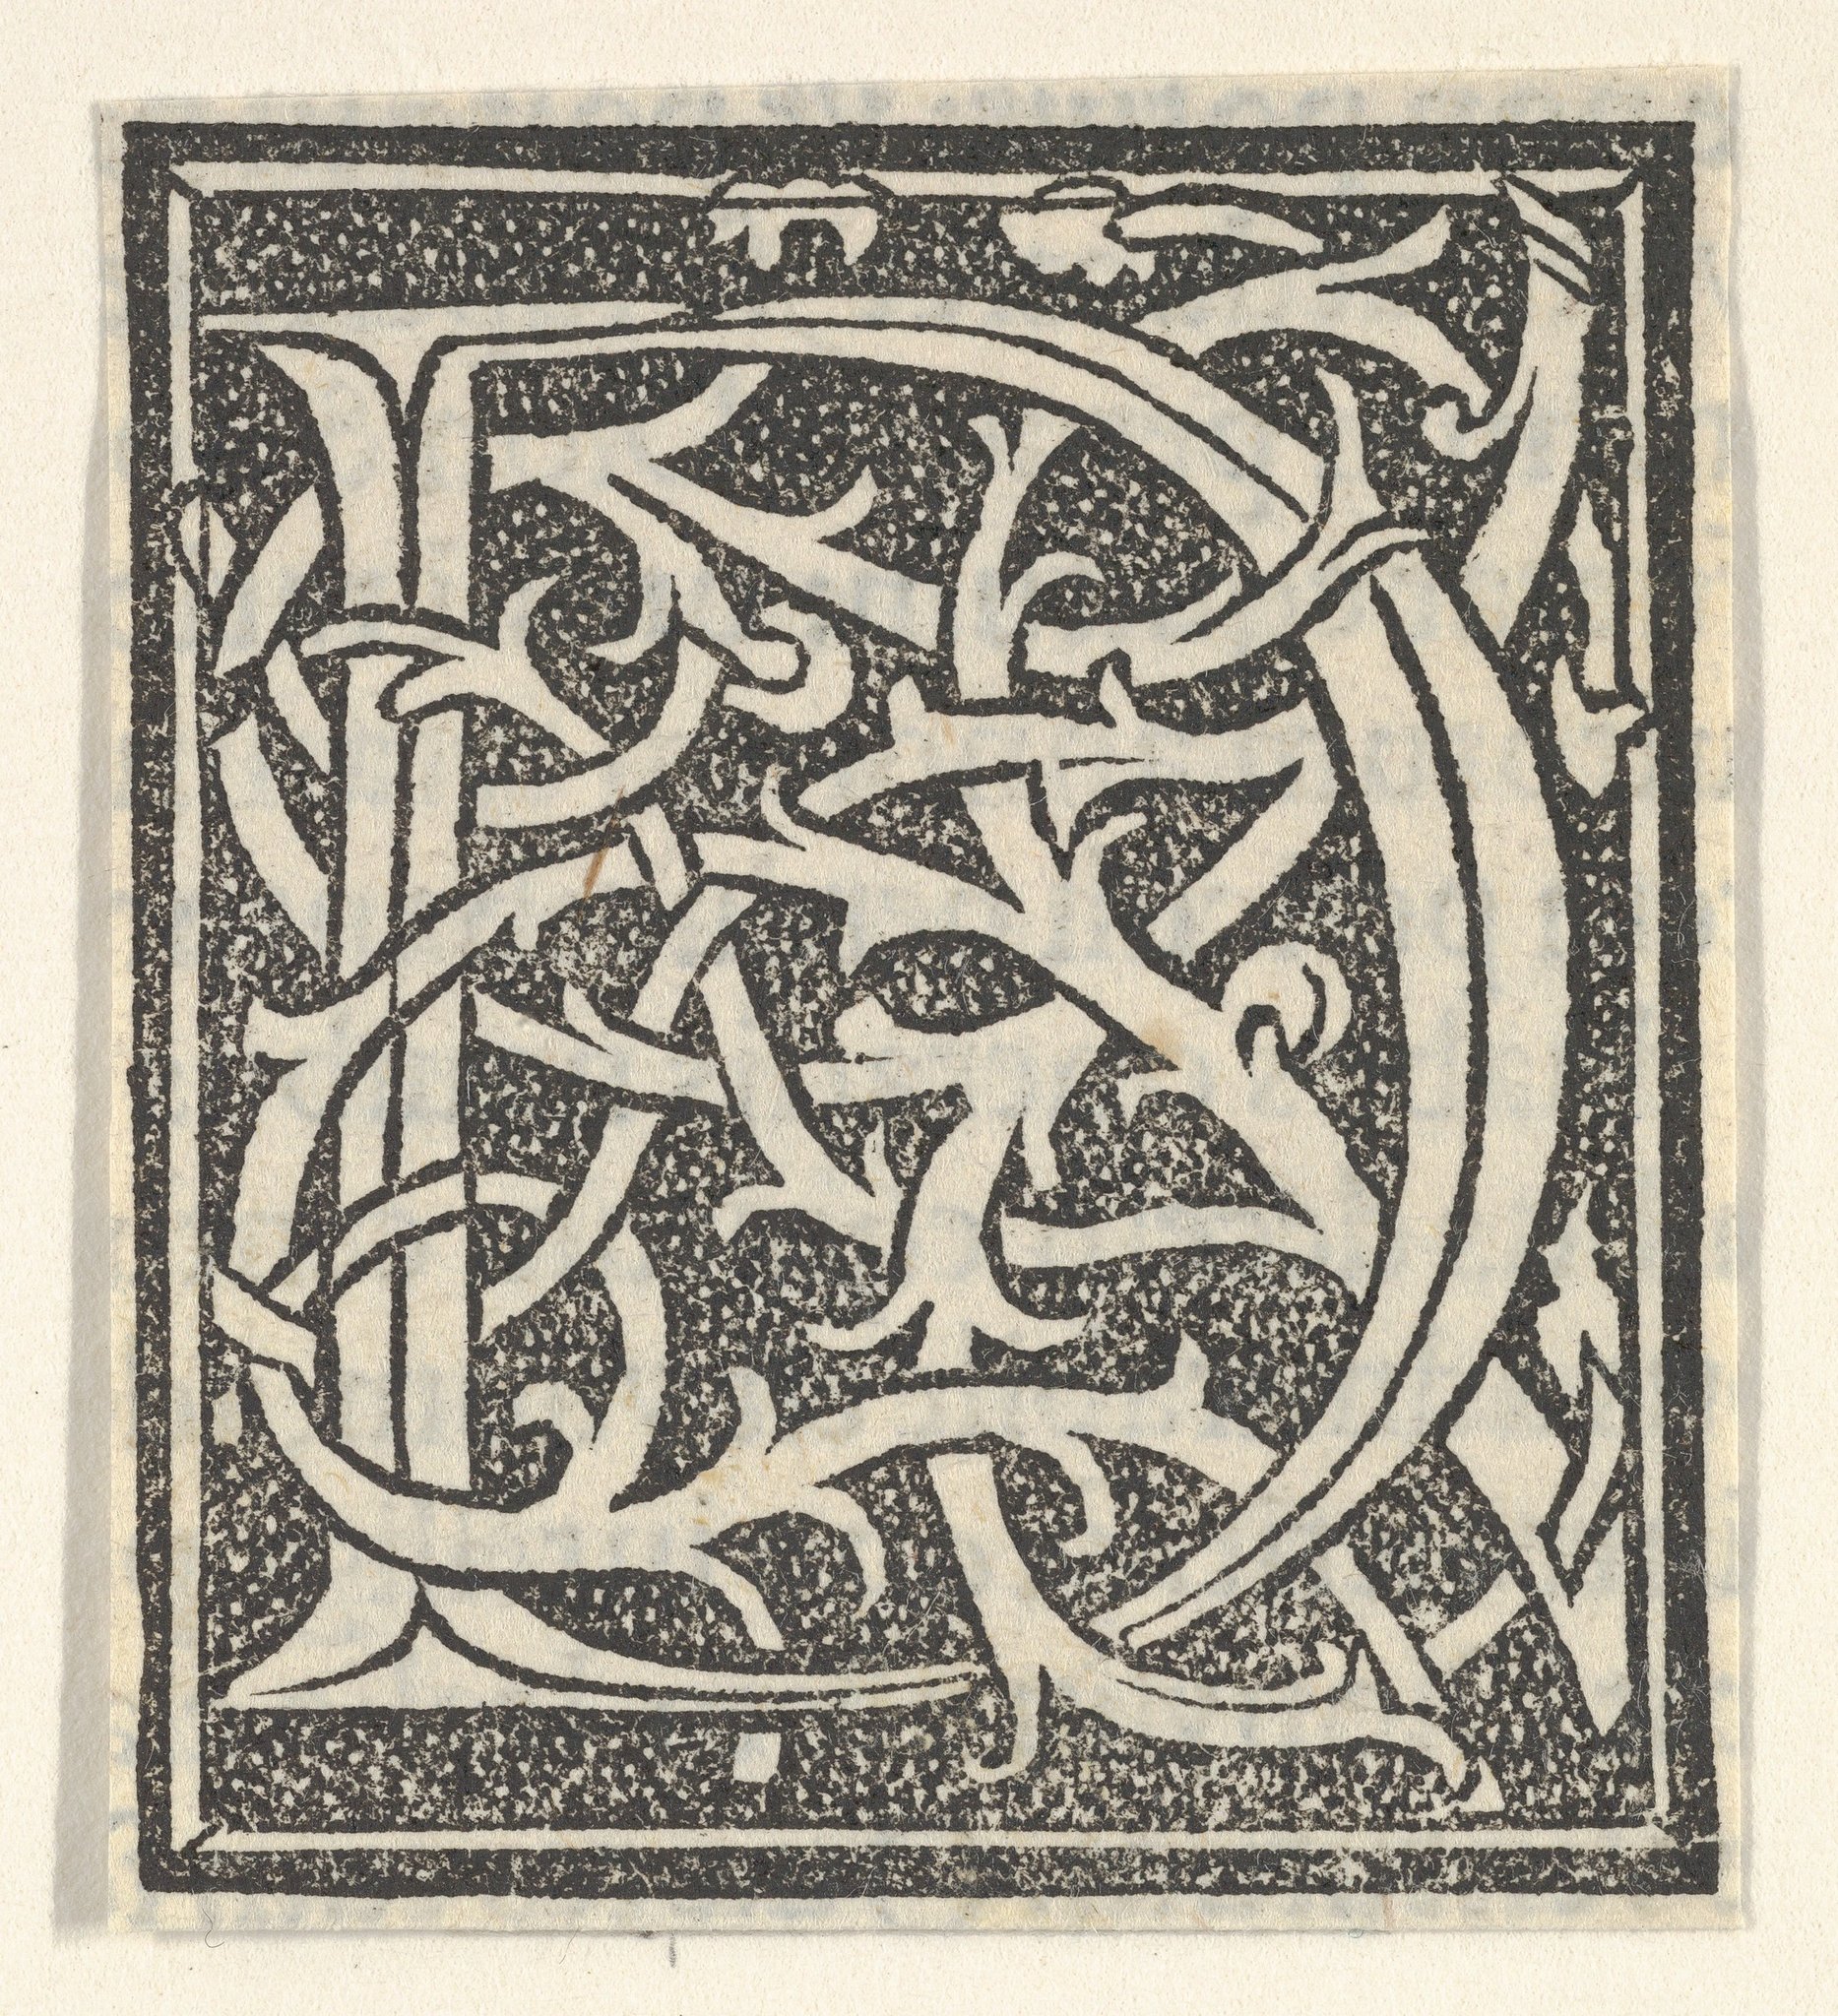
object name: print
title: Initial letter D on patterned background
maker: anonymous, italian, 16th century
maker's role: artist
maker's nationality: italian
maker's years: 1500-1600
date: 1520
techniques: woodcut